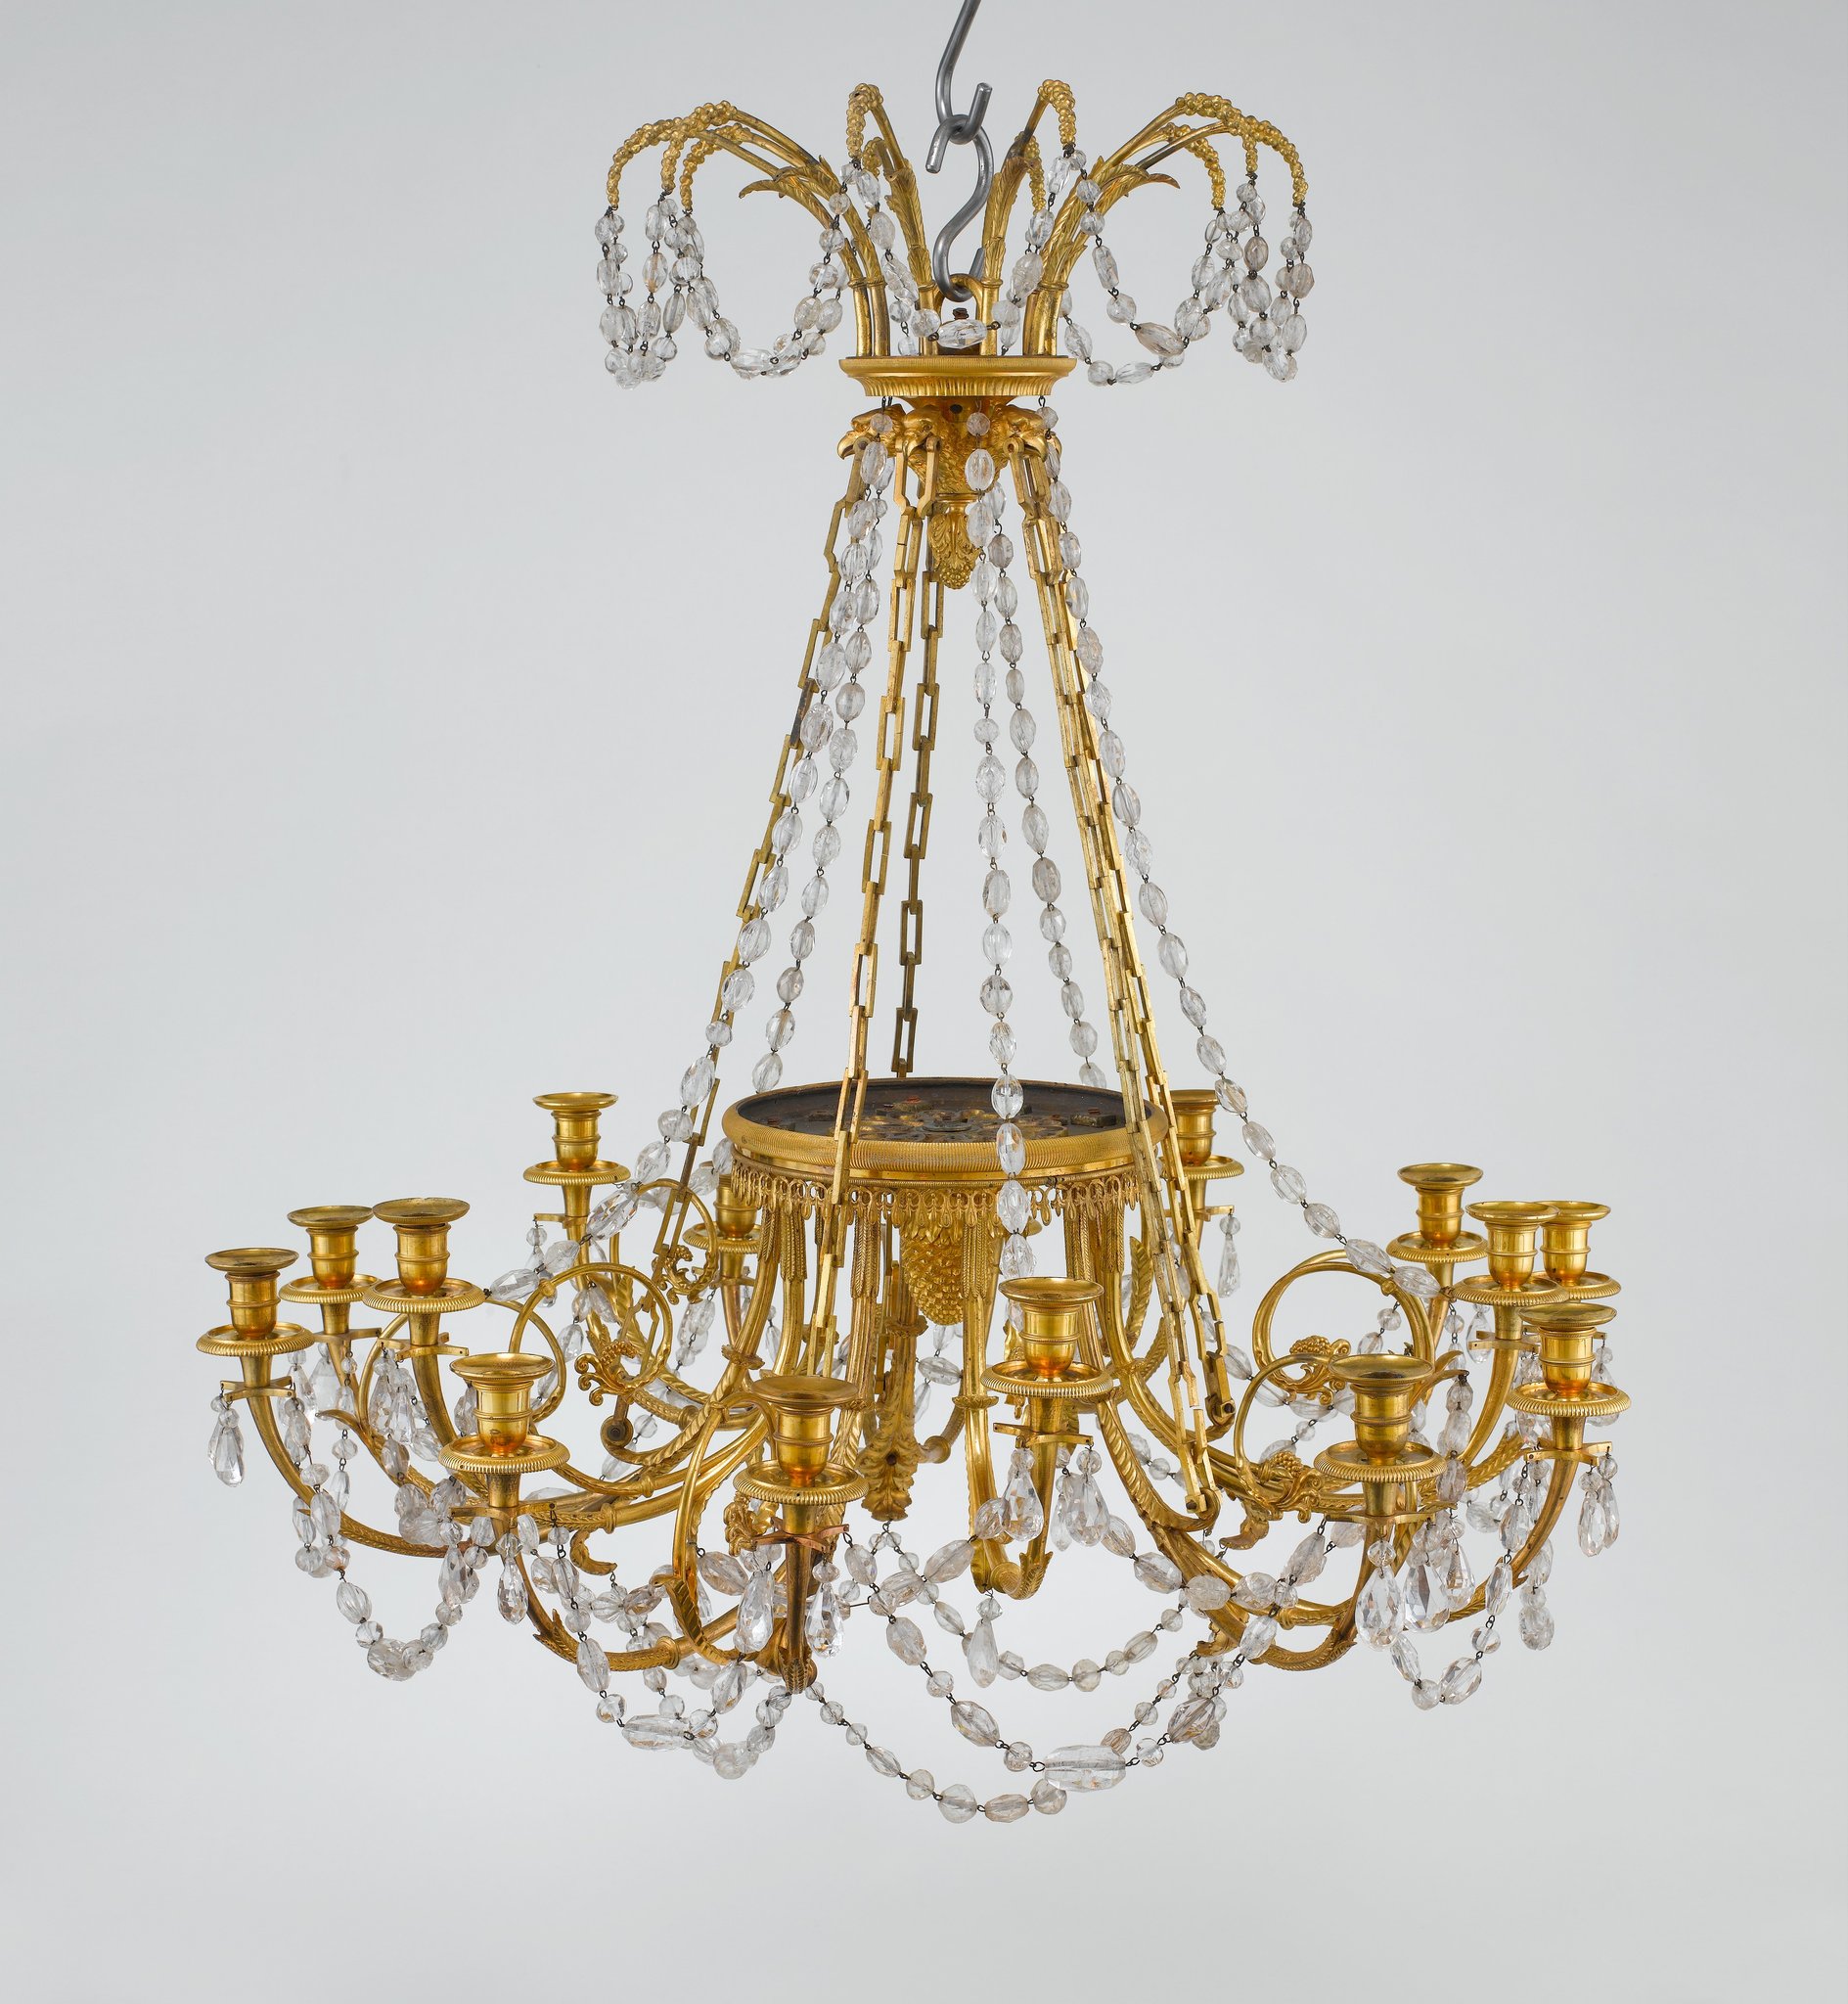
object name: chandelier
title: Fifteen-light chandelier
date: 1785-1790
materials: gilt bronze, quartz